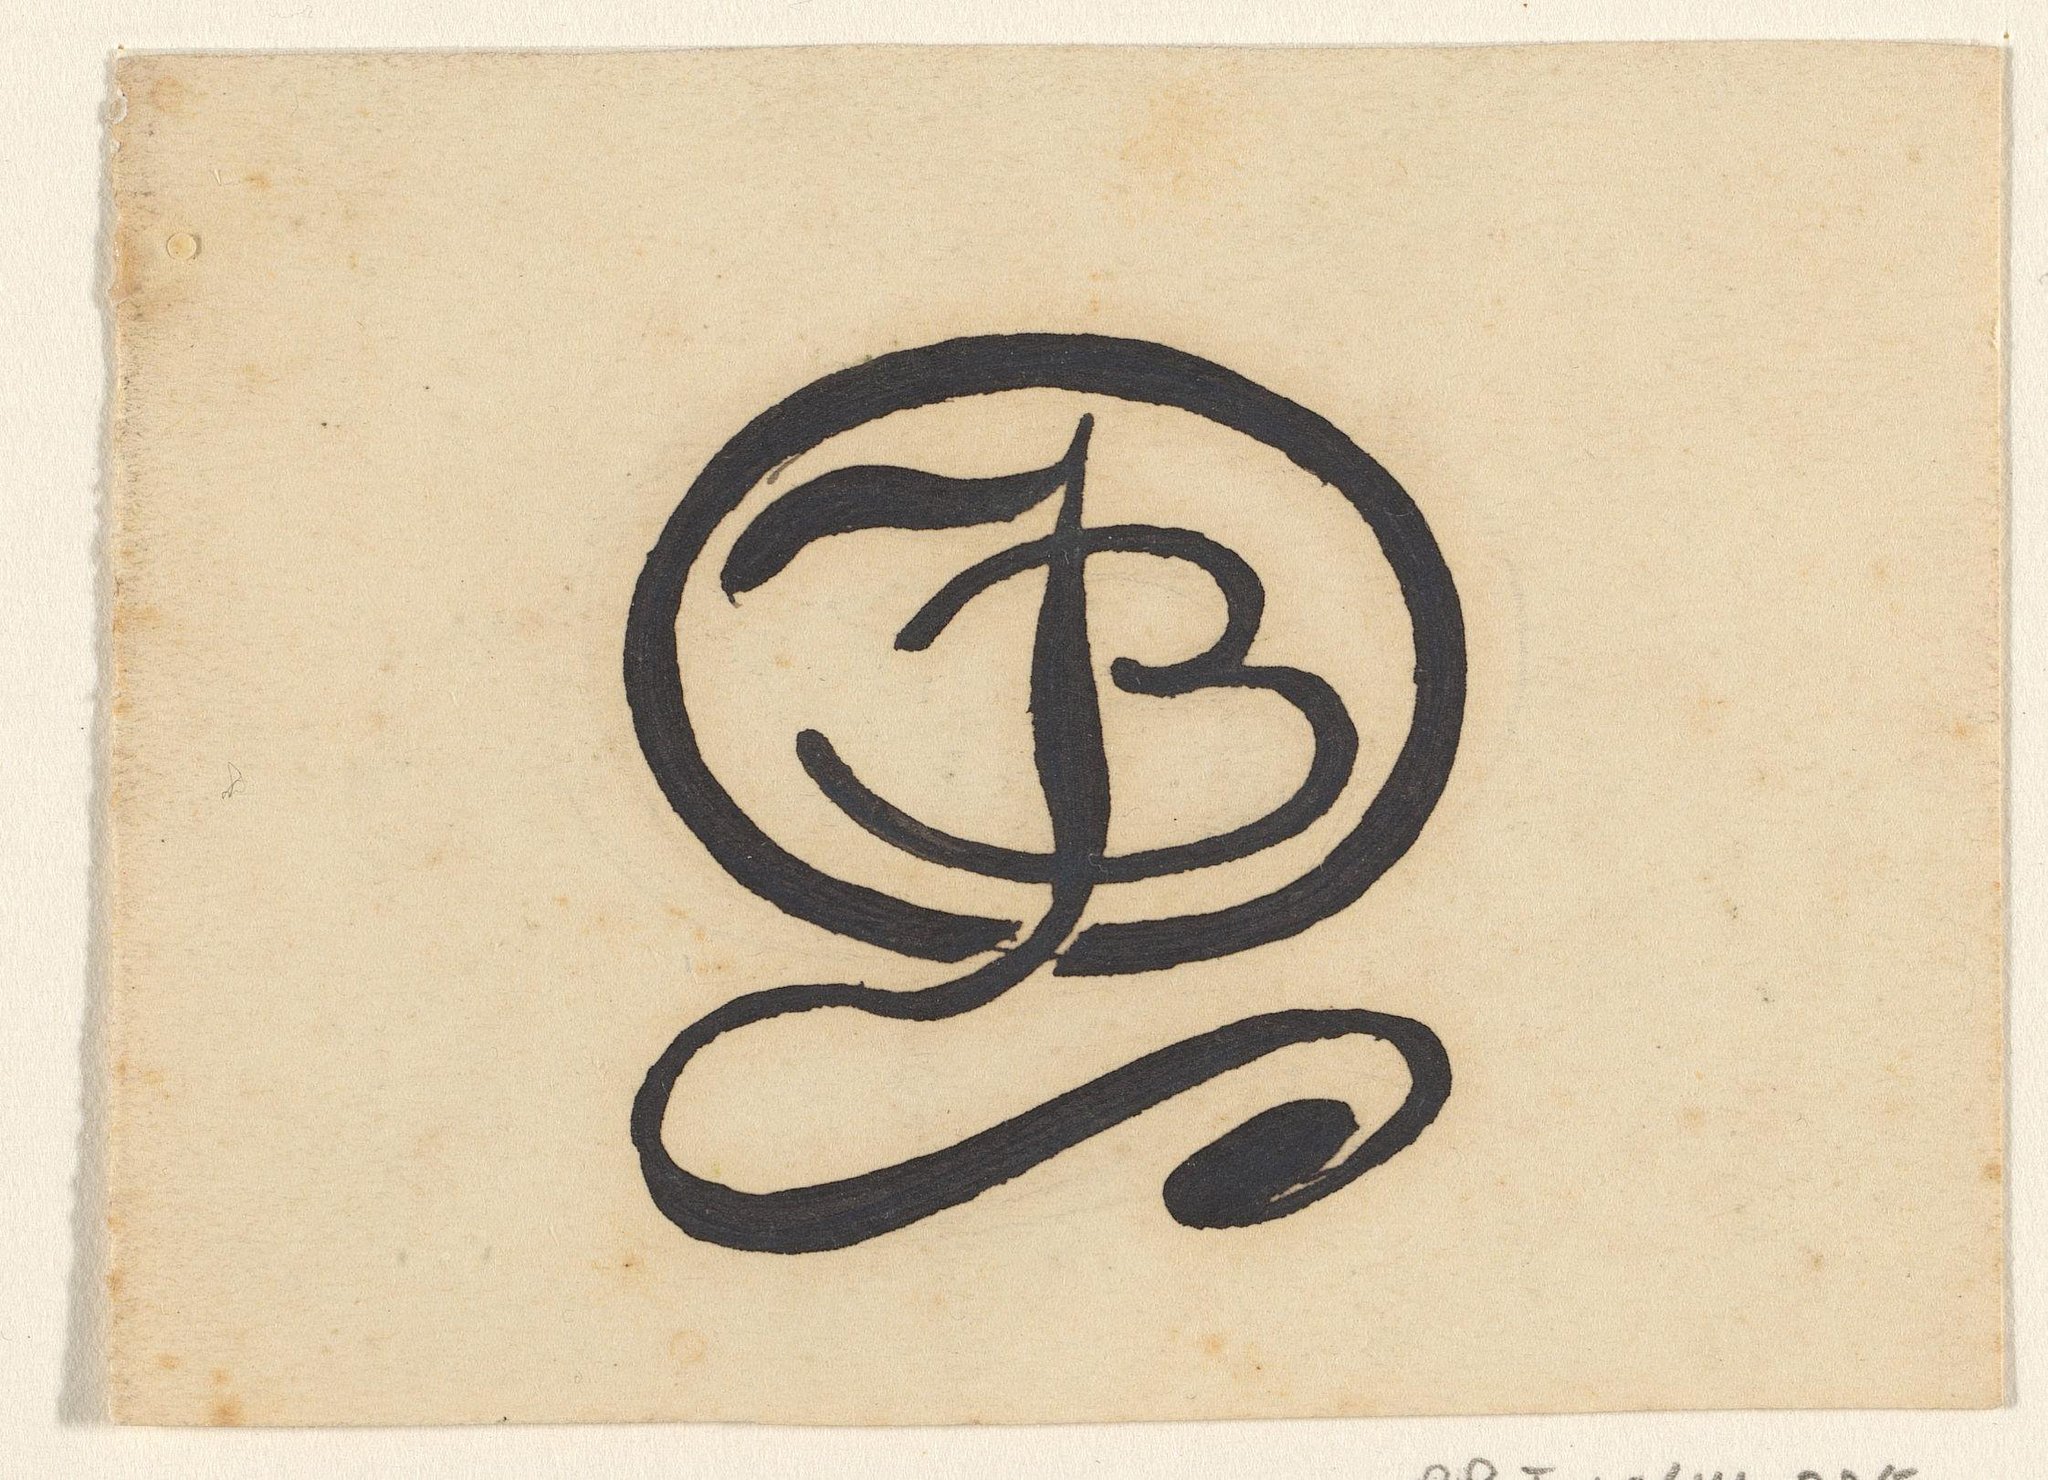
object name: drawing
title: Ontwerp voor een monogram met de letters J en B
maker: antoon derkinderen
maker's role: draughtsman, painter, print maker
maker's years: 1859-1925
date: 1869-1925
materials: ink, paper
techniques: pen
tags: letter combinations such as letterword, anagram, letter square, monogram, etc.